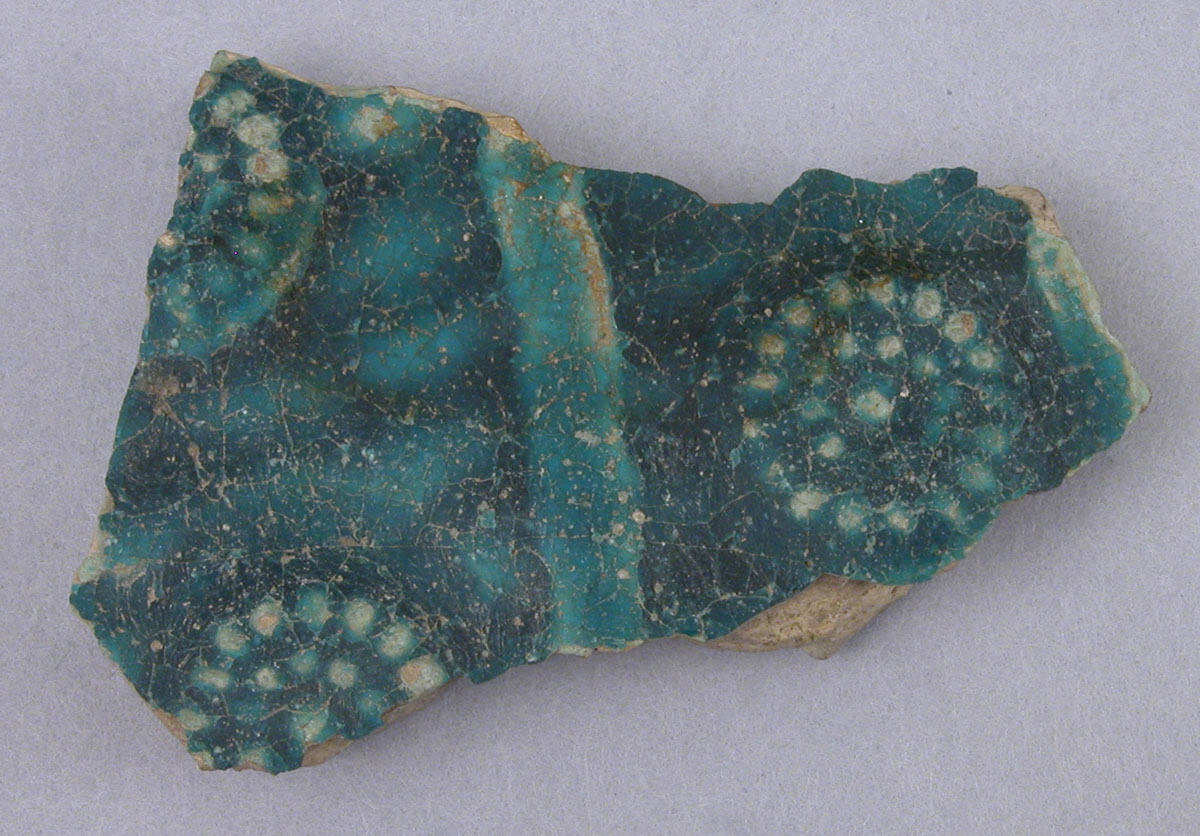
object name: fragment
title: Ceramic Fragment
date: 801-1000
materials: earthenware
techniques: glazing, molding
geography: saudi arabia